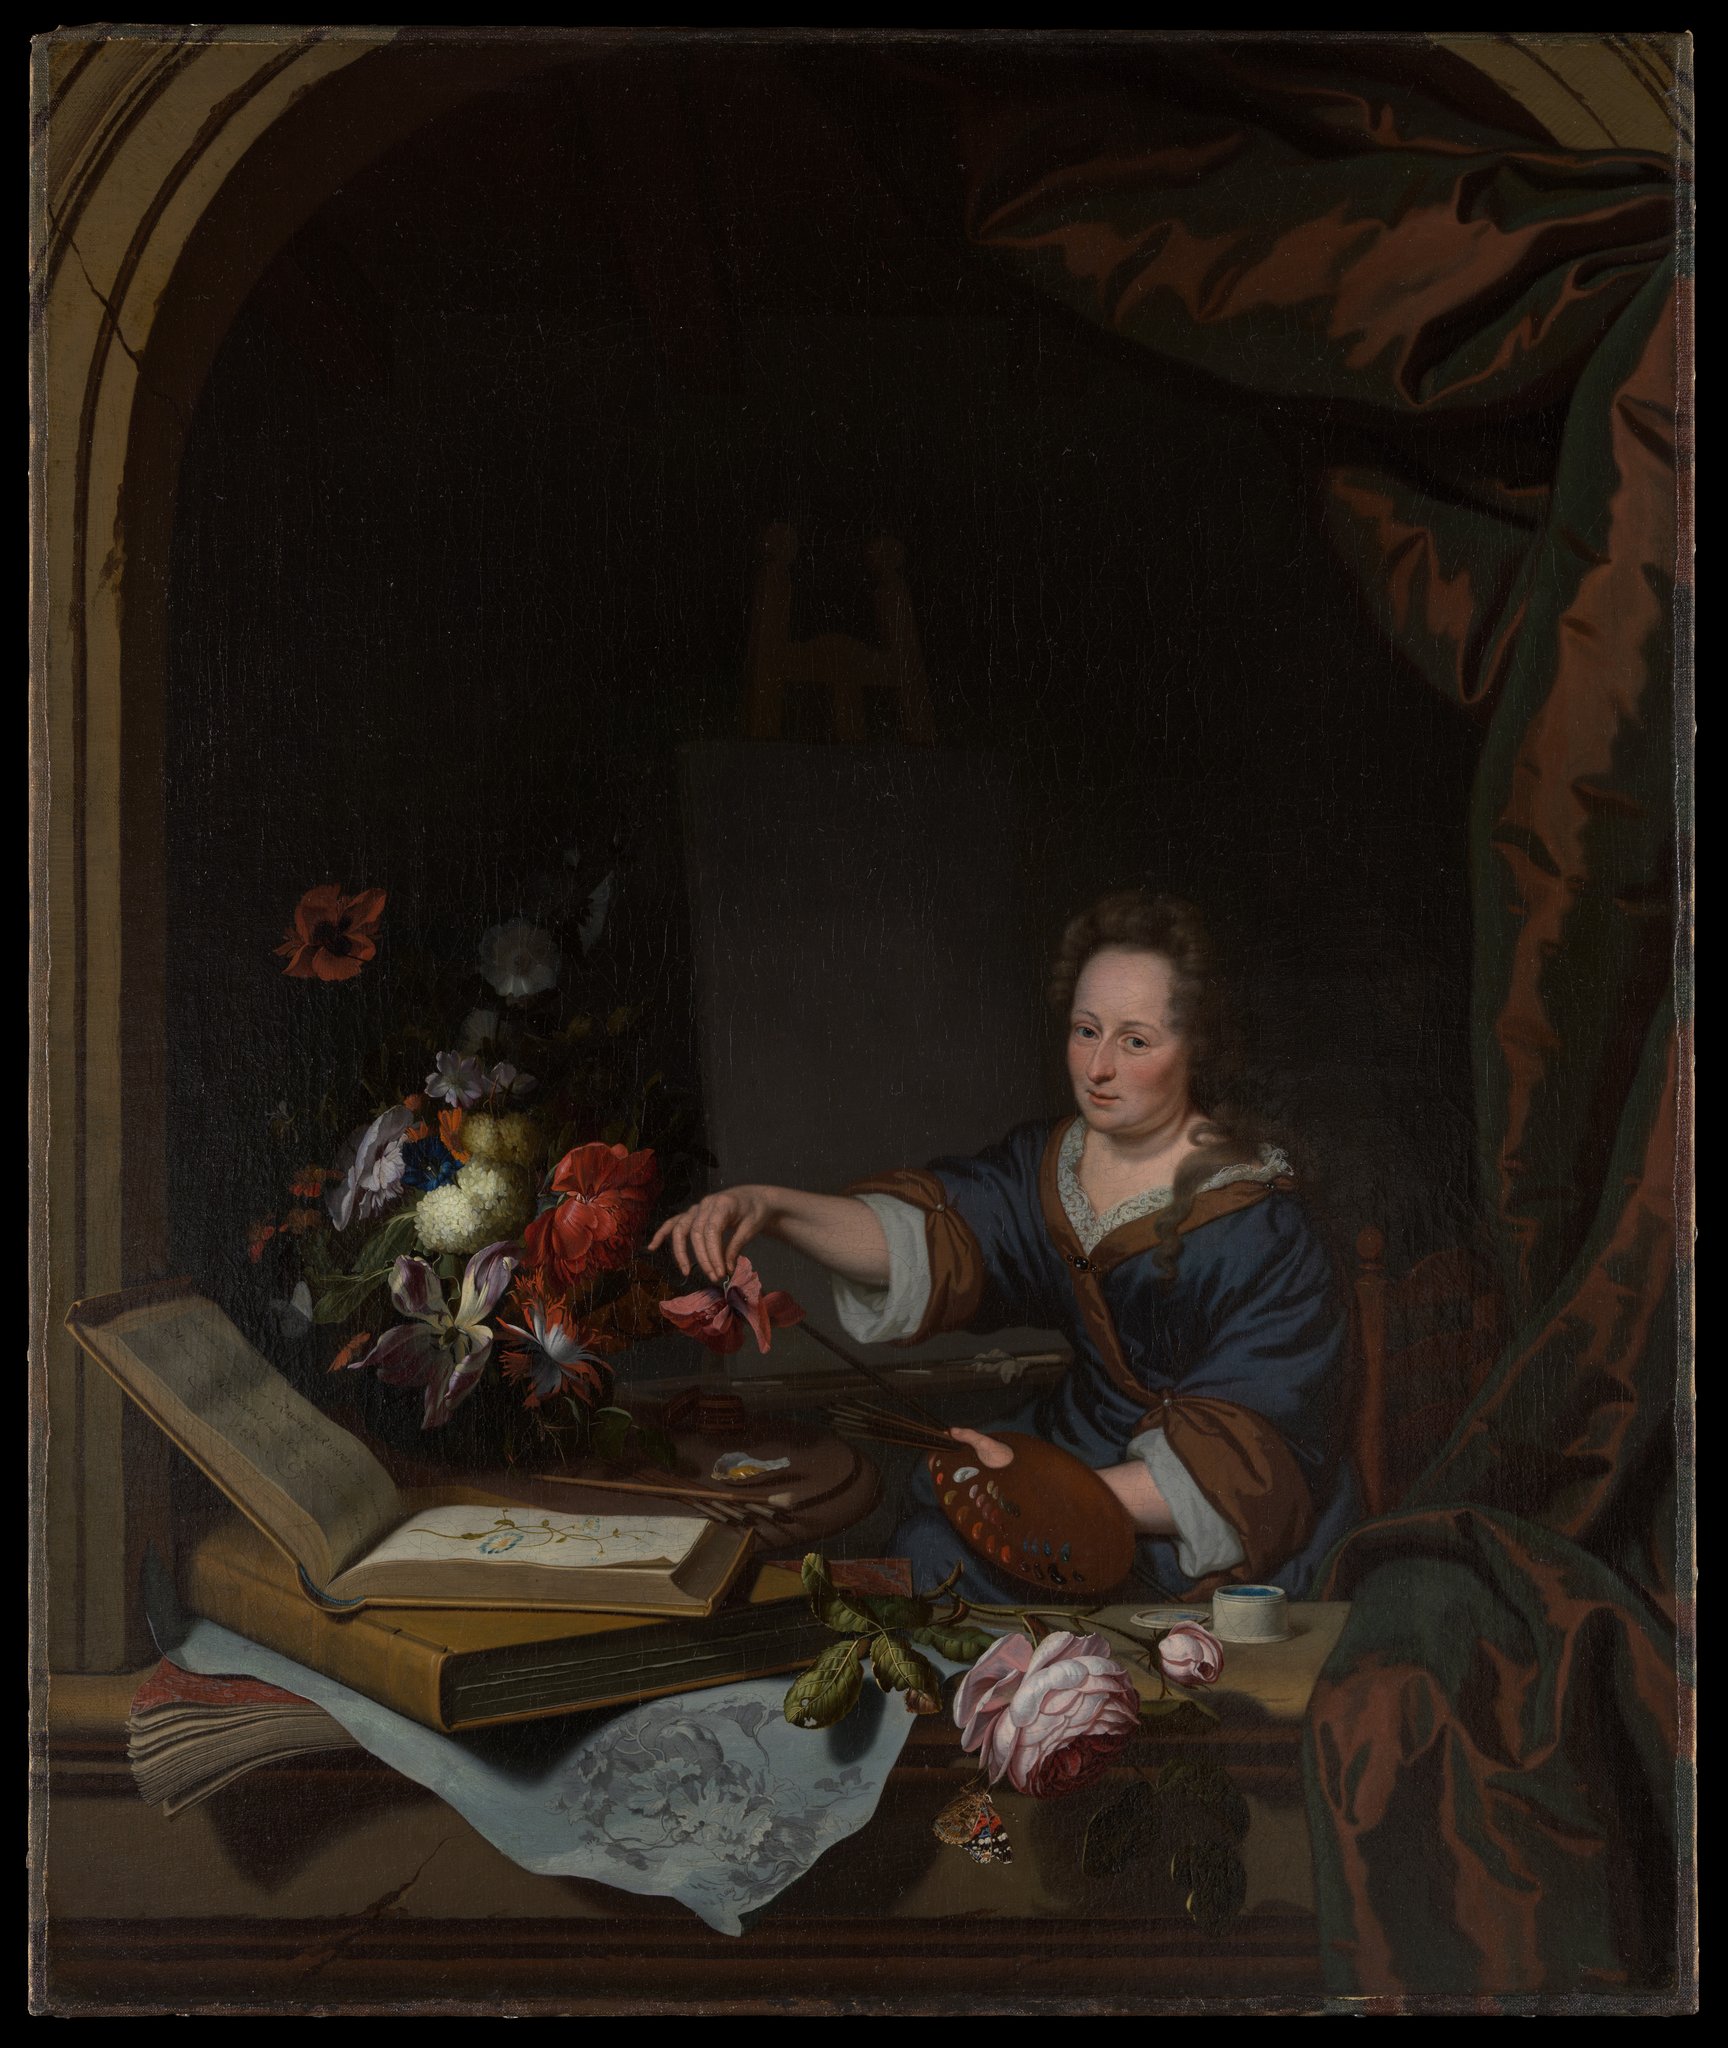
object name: painting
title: Rachel Ruysch (1664–1750)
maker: rachel ruysch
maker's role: artist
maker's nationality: dutch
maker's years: 1664-1750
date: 1692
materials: canvas, oil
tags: women,butterflies,flowers,artists,palettes